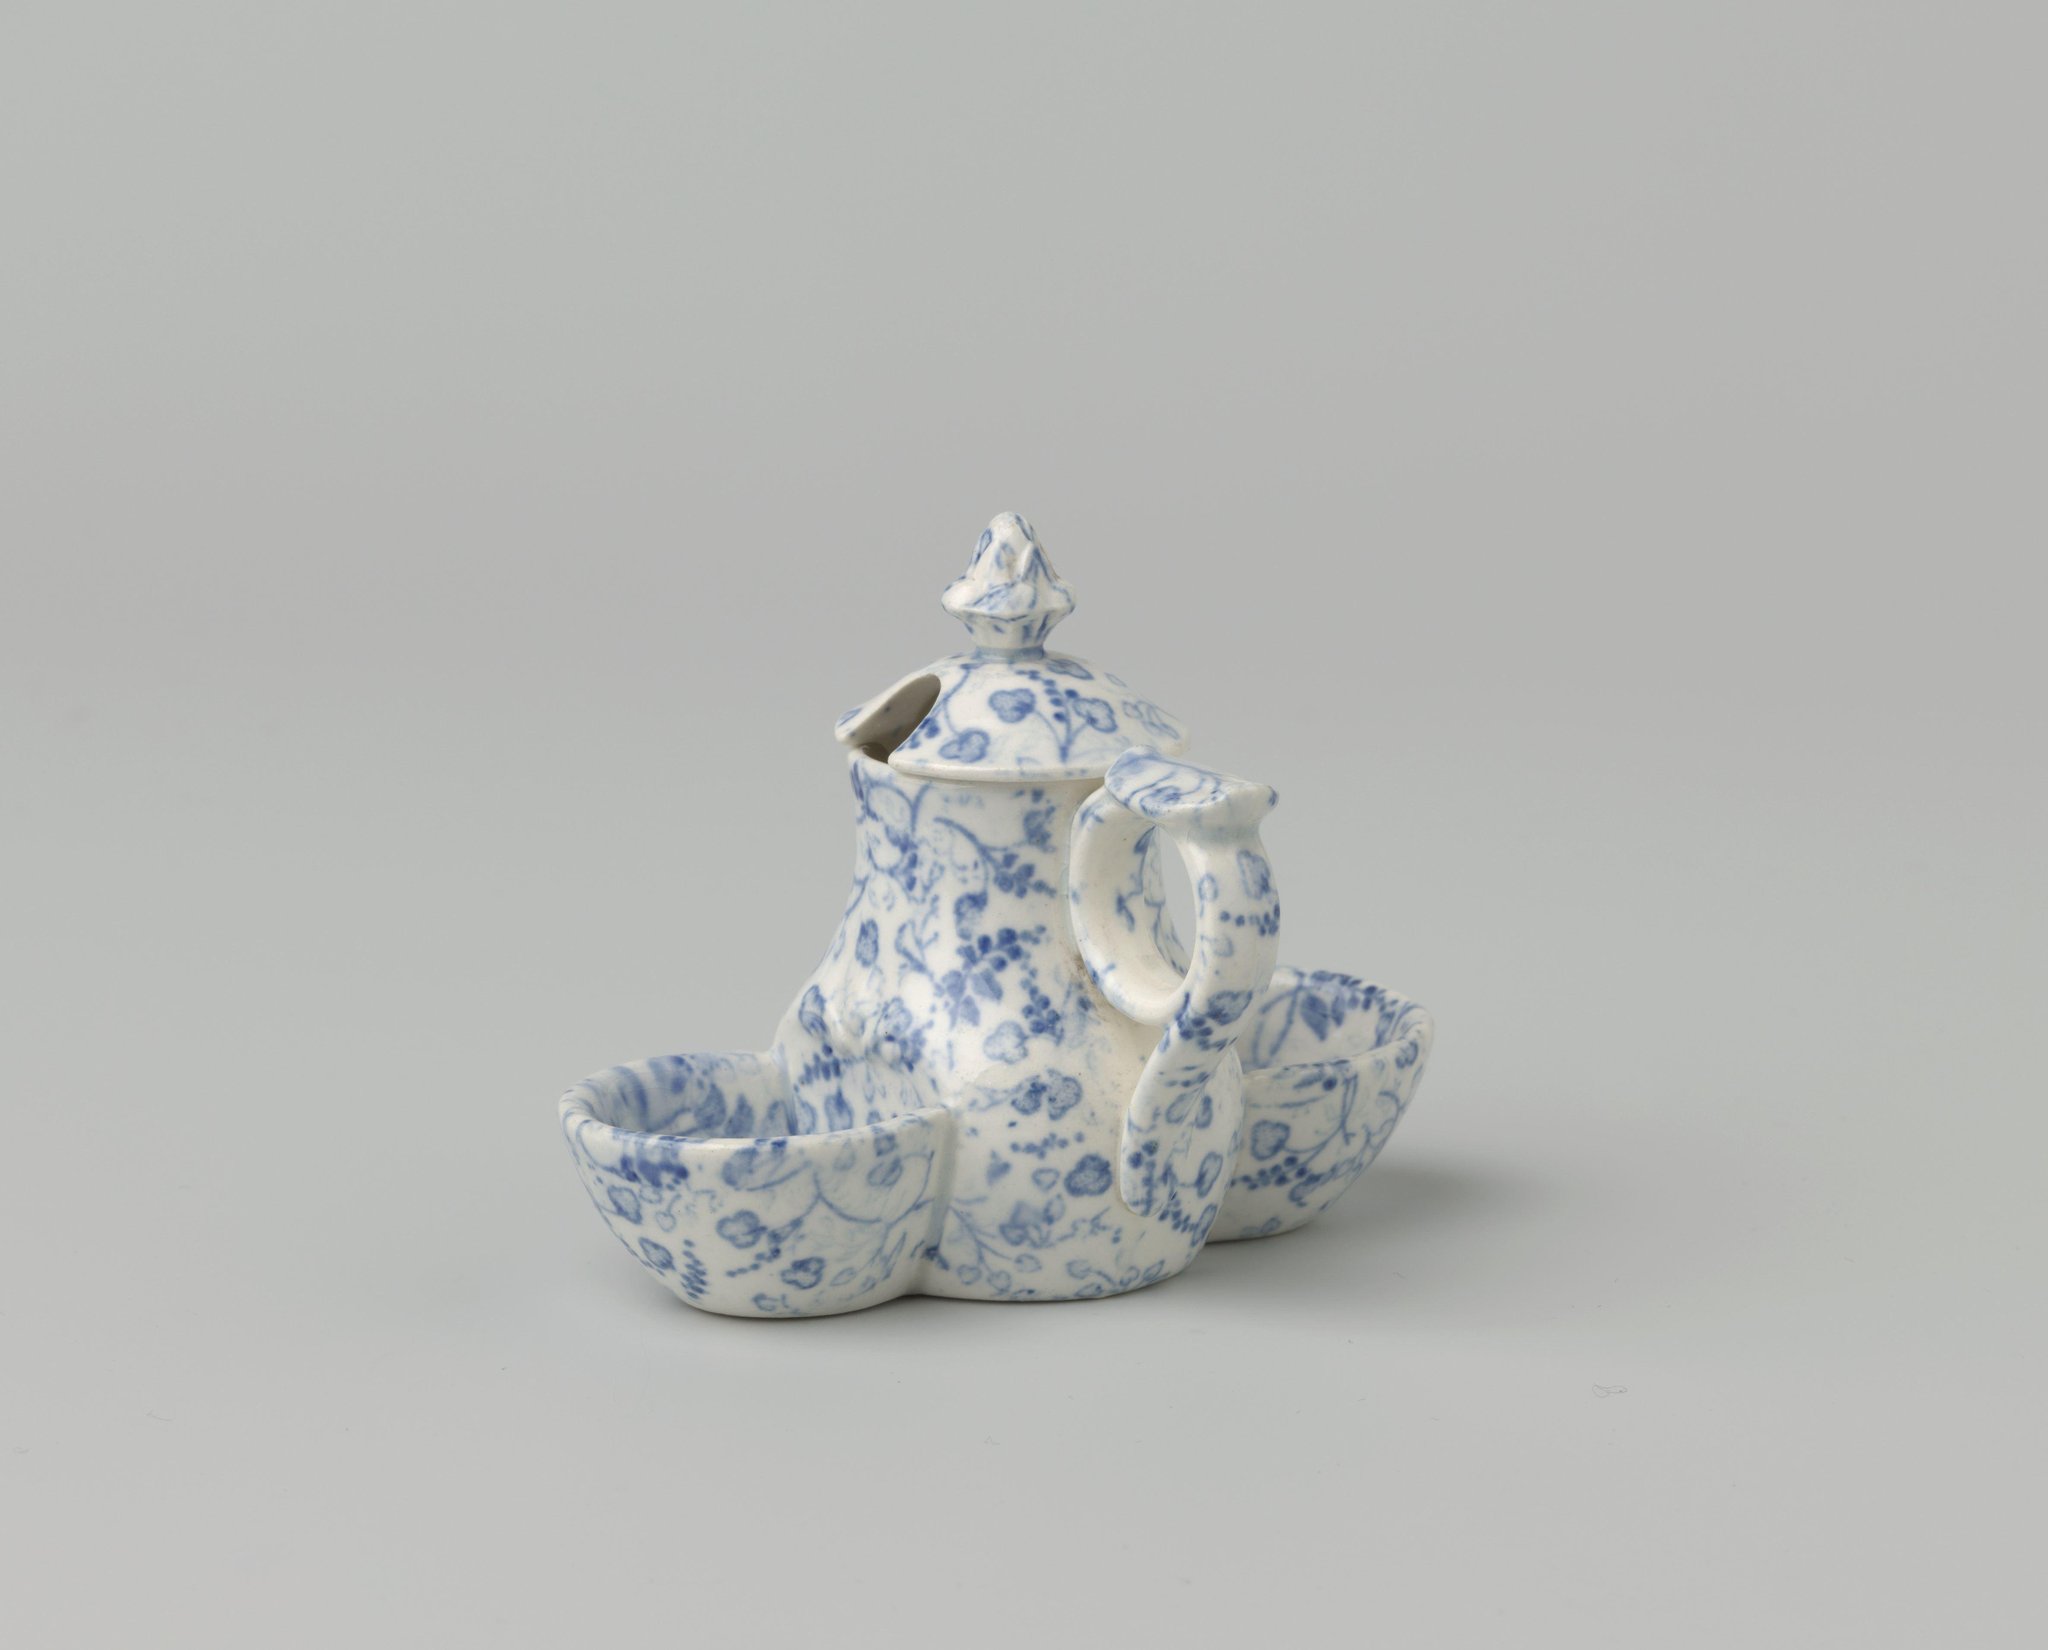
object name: vessel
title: Trois usages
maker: petrus regout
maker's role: plateelbakker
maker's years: 1801-1879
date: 1867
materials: creamware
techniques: transfer decoration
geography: maastricht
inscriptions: check stamp: ‘PR // 31 (?)’, mark: ‘PARSEME No 3’, check stamp: ‘33’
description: Trois usages van aardewerk met blauw doorlopend bloemendecor, behorend tot een kinderservies. Aan weerszijden van de mosterdpot twee halfbolvormige bakken. De mosterdpot heeft een oor, waarvan de duimgreep wordt gevormd door een blad.